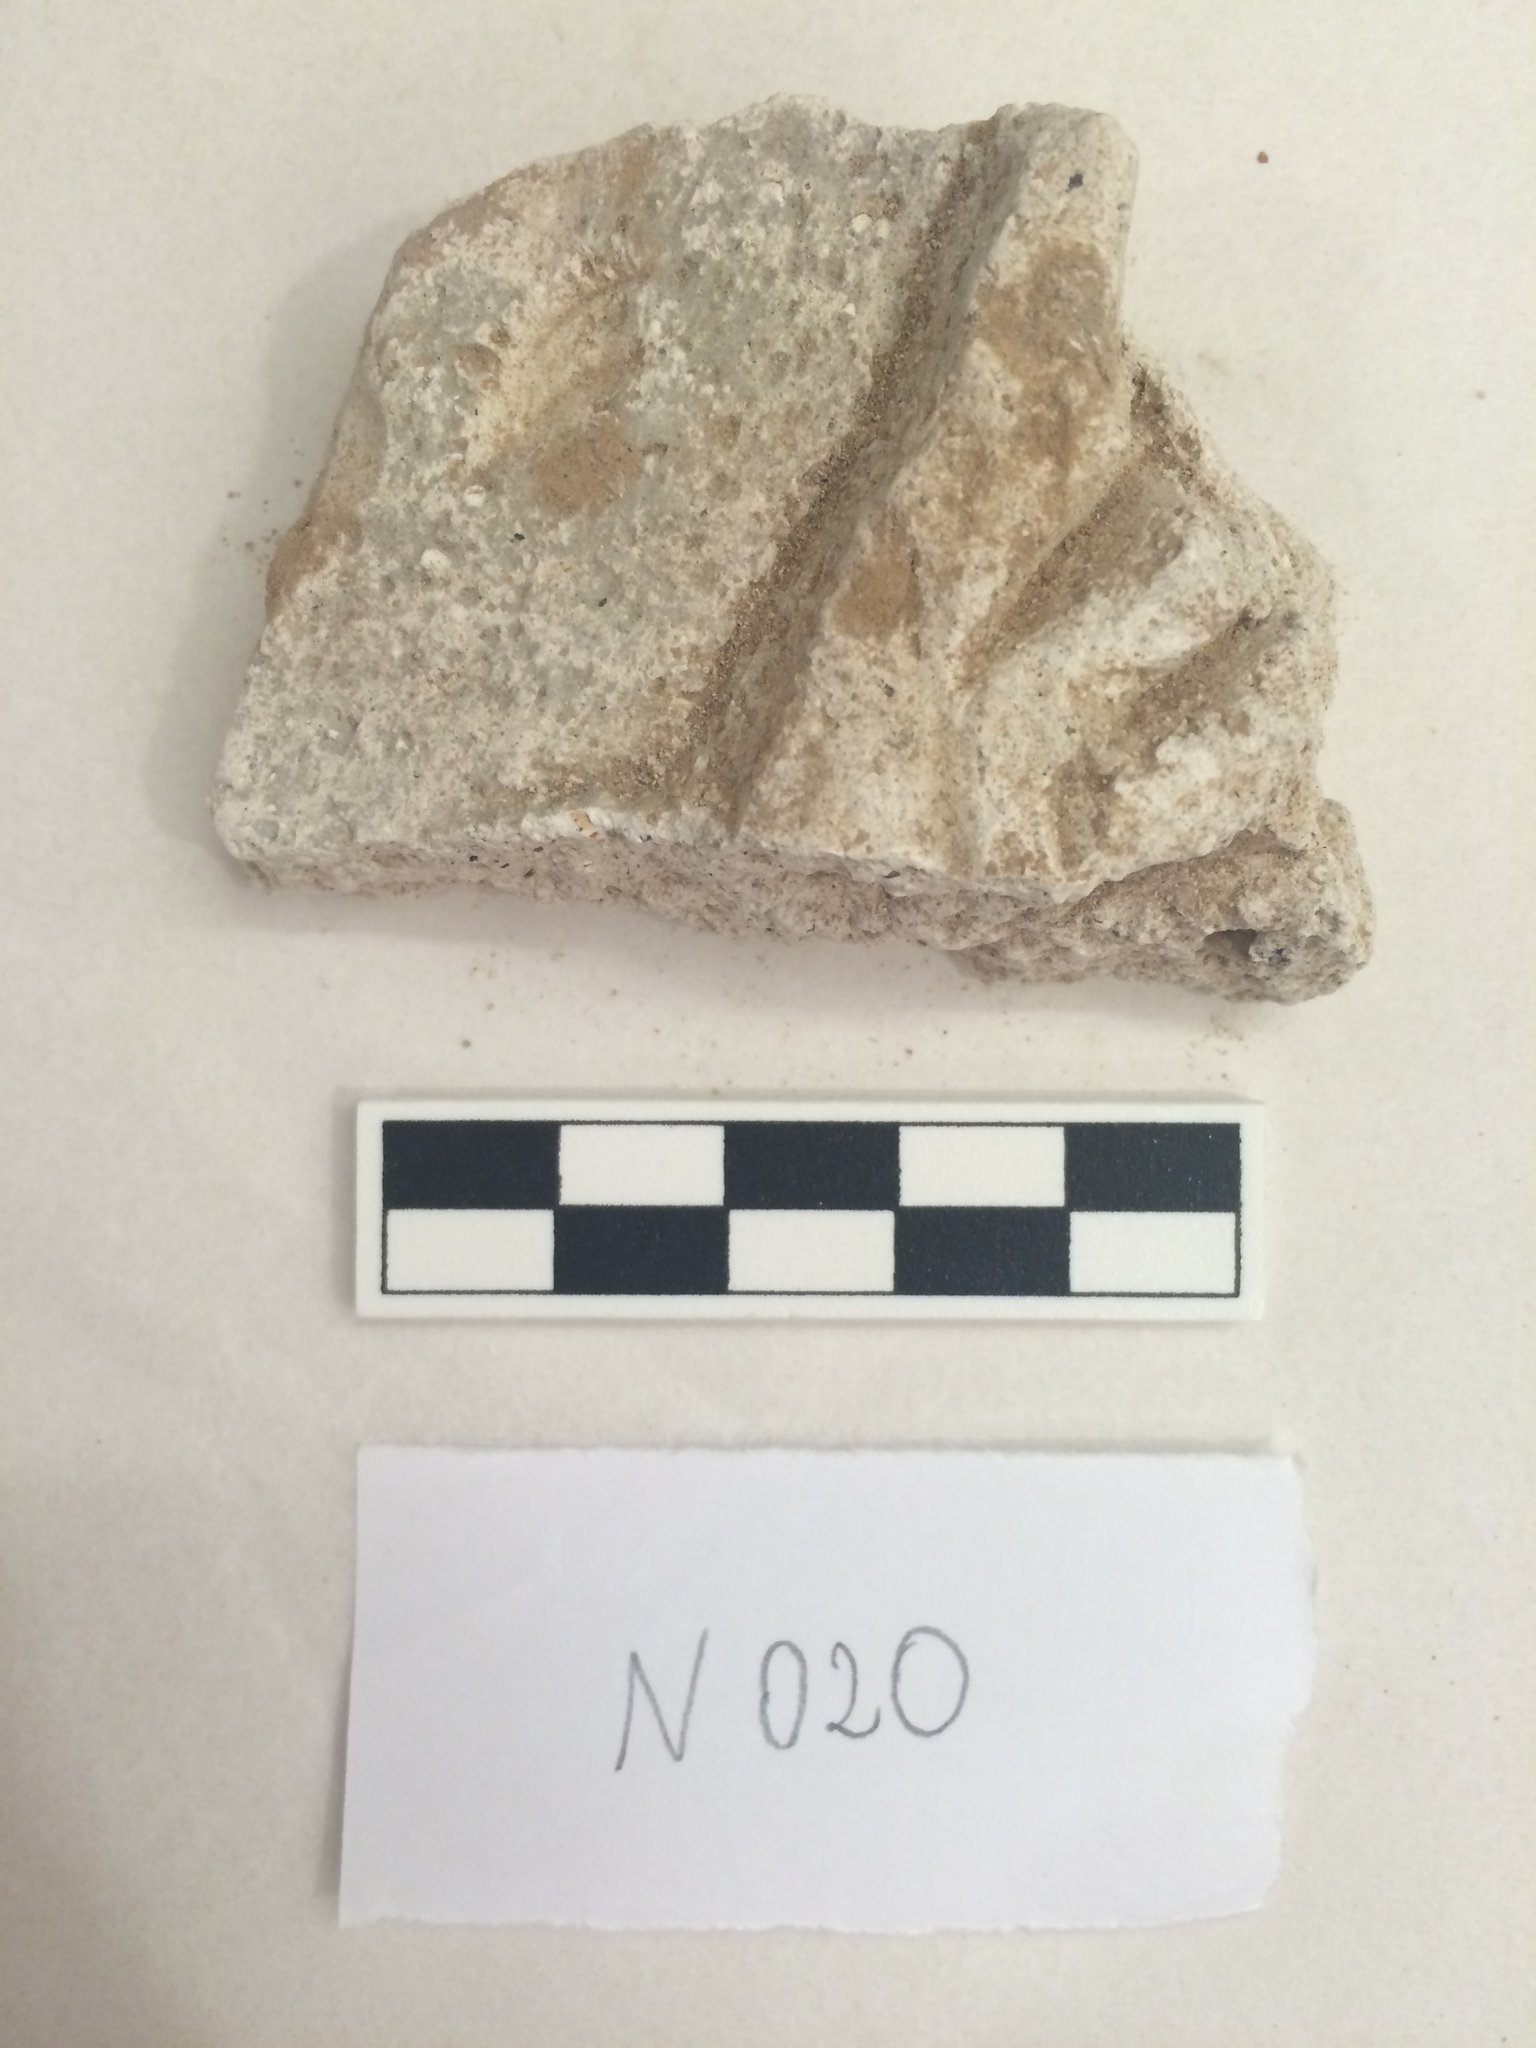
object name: fragment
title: Stucco Fragment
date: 701-1200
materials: plaster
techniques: carving, painting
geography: iran